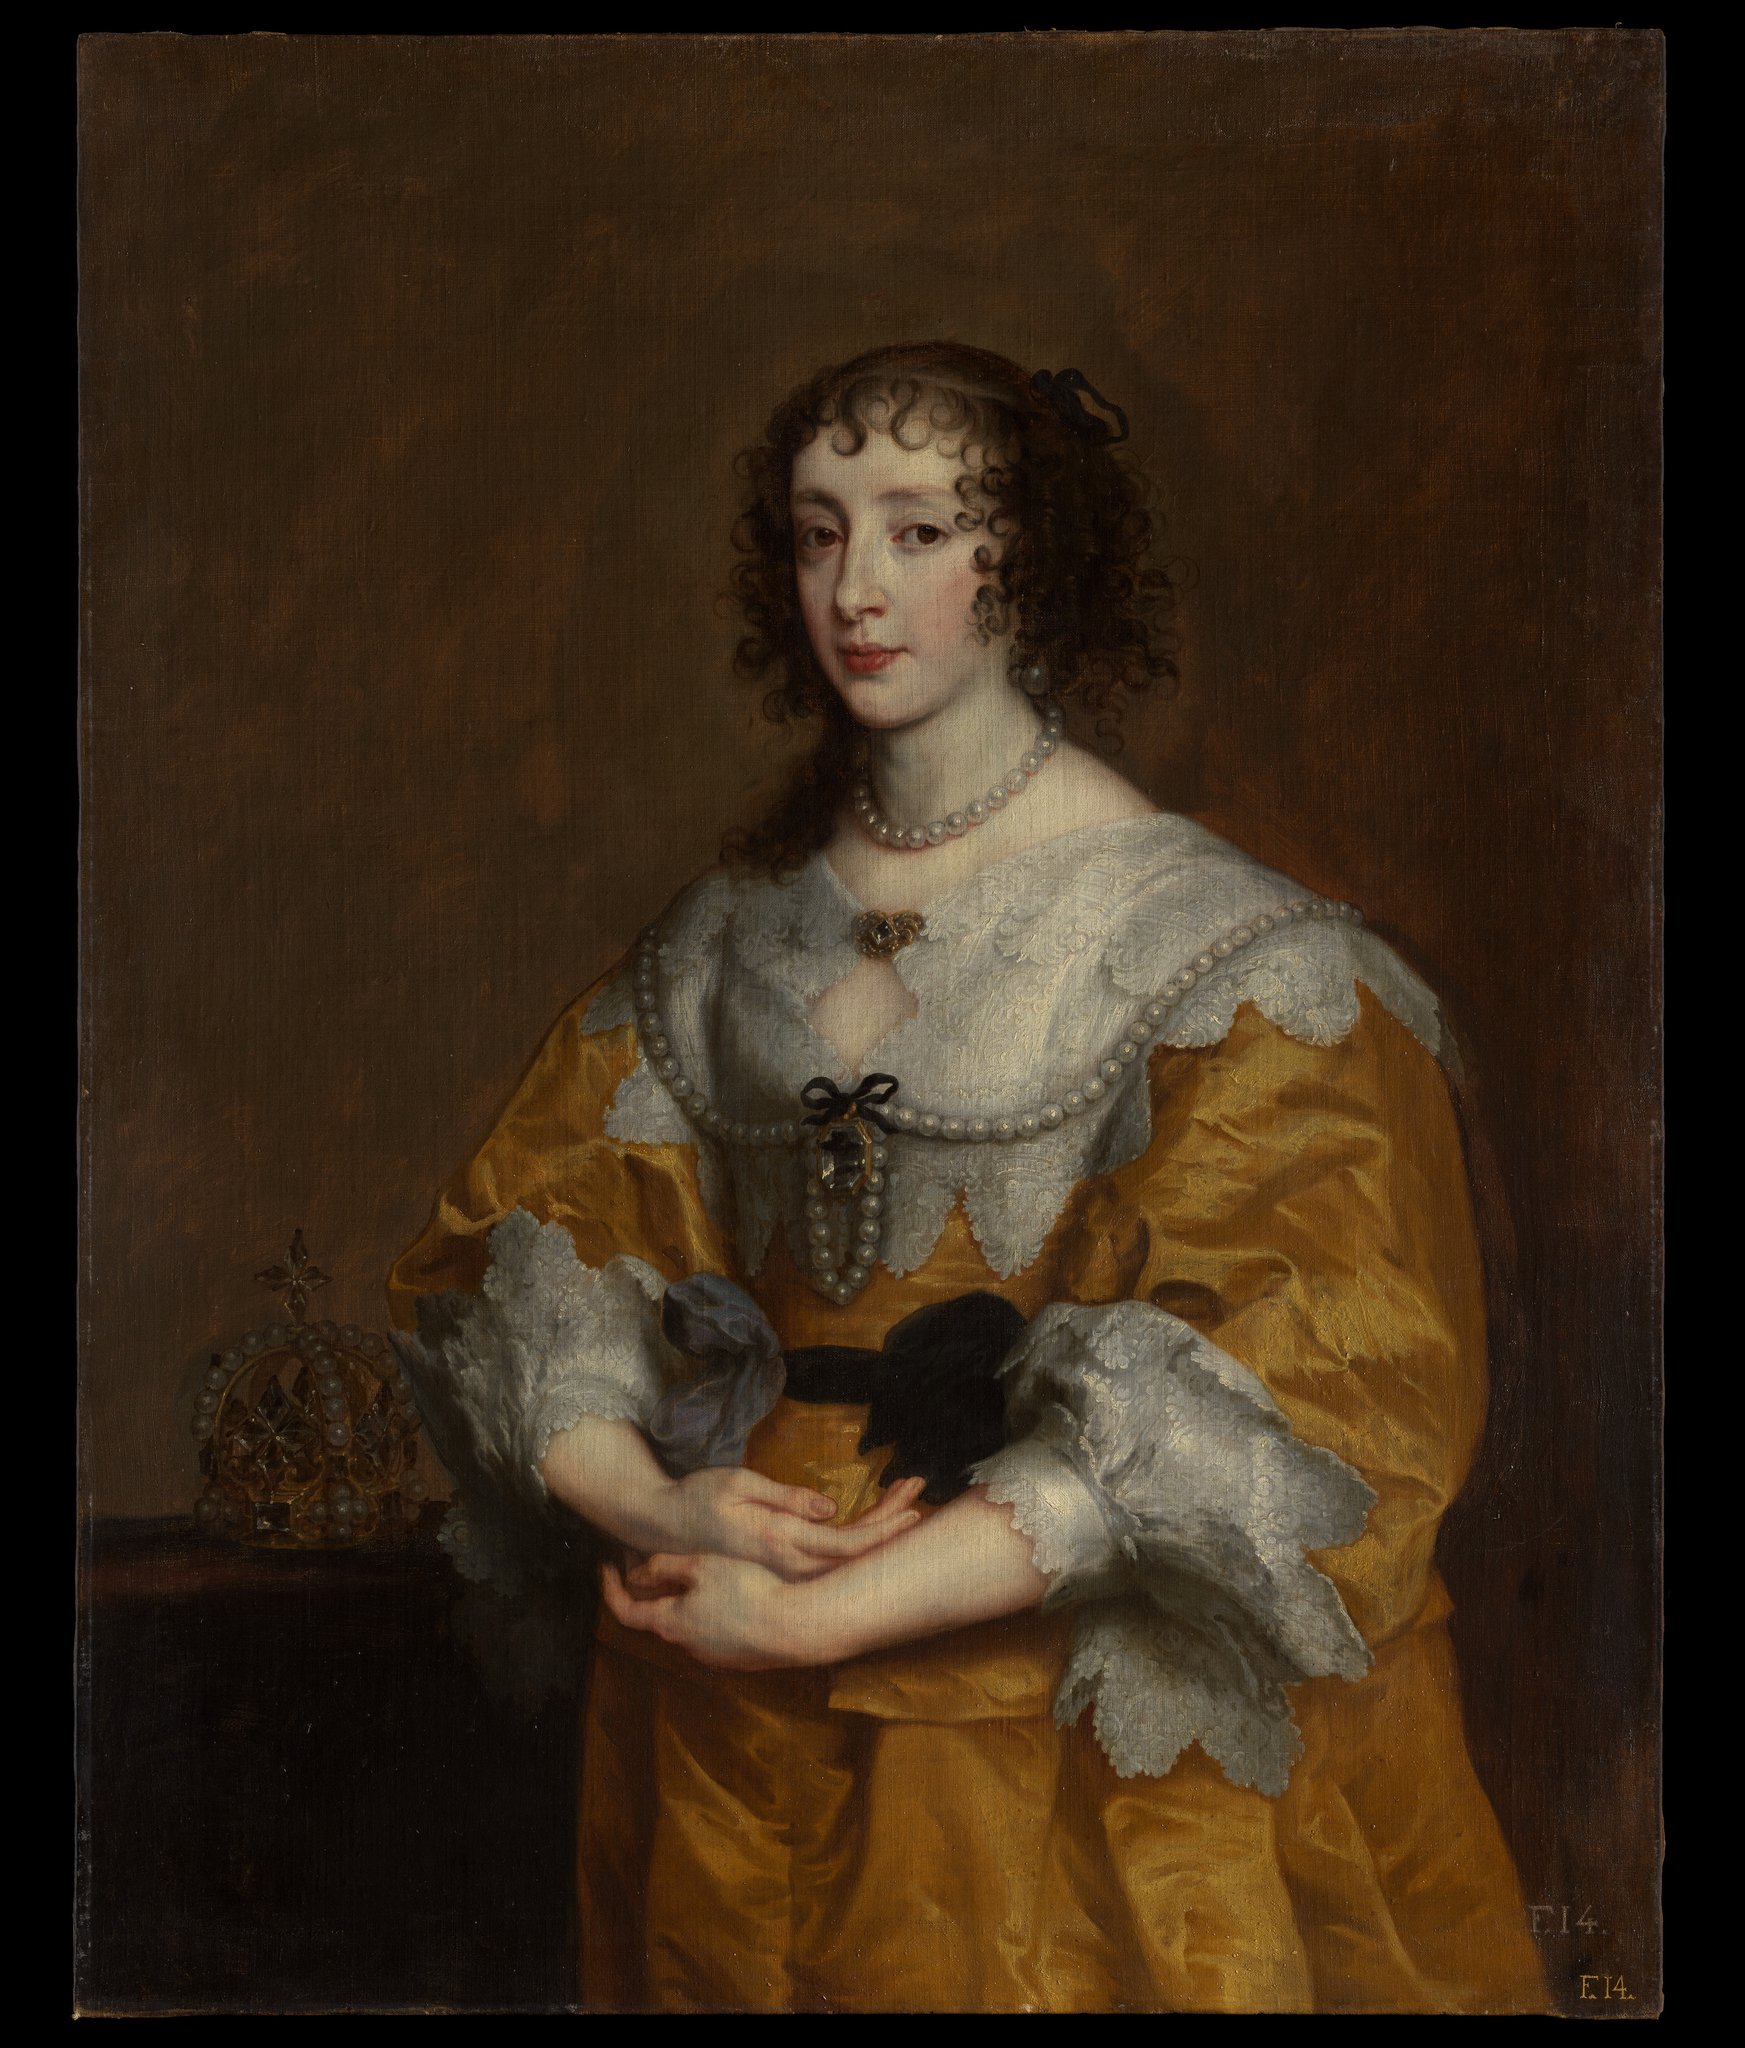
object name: painting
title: Queen Henrietta Maria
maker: anthony van dyck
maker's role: artist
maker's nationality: flemish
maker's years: 1599-1641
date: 1636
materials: canvas, oil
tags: queens,portraits,women,crowns